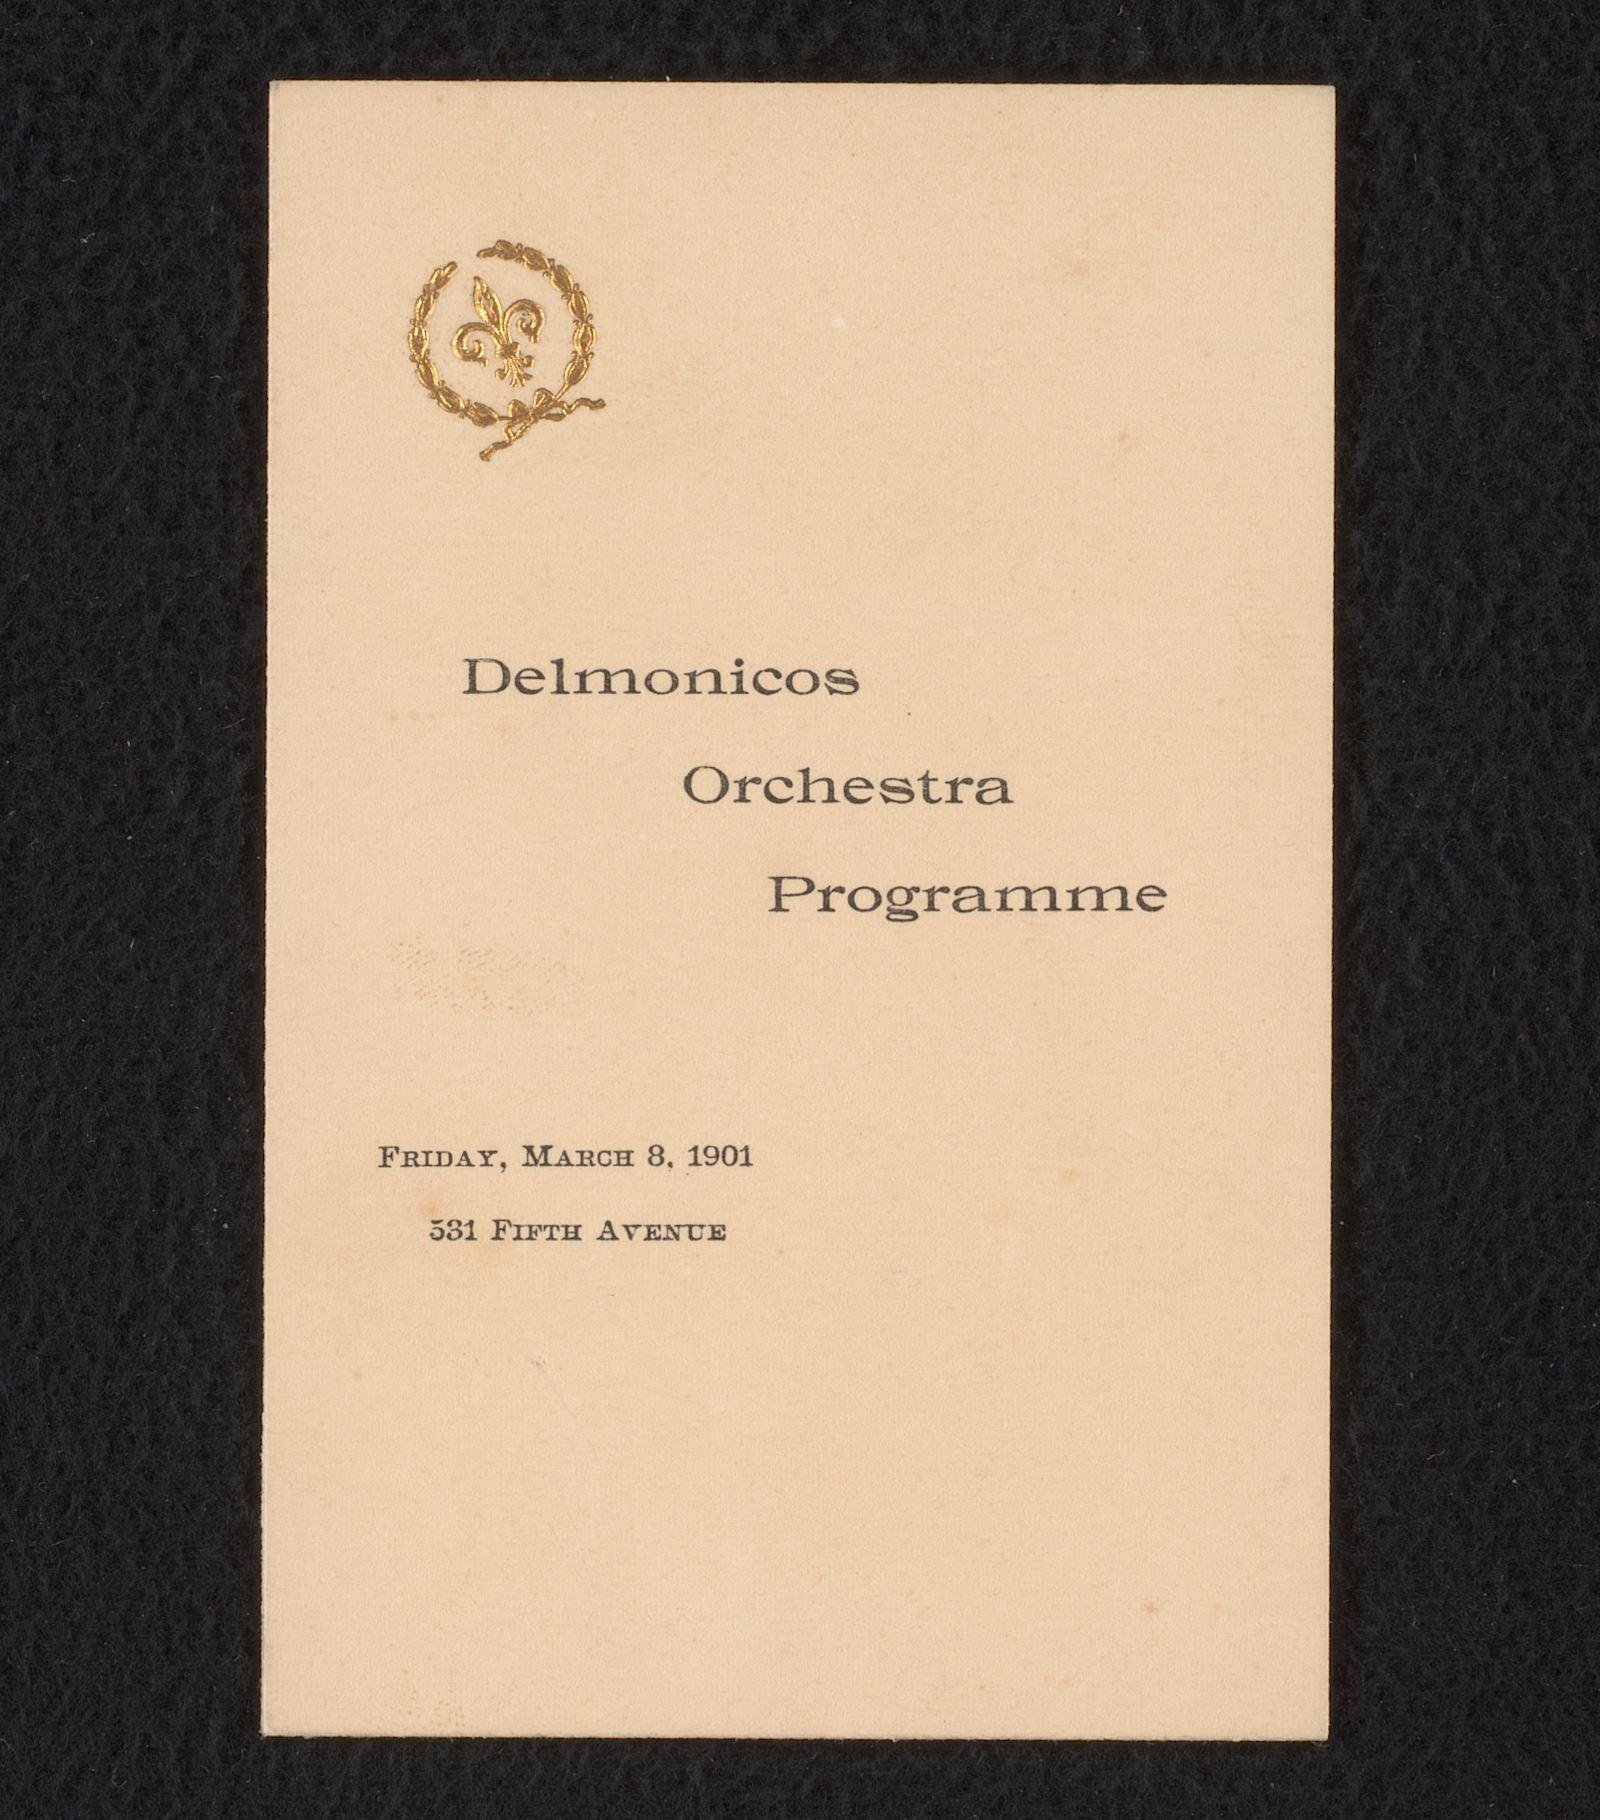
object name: text sheet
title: Programma van het concert van het Delmonicos Orchestra op 8 maart 1901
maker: Anonymous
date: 1901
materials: paper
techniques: printing, letterpress printing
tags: fleur-de-lis ~ ornament, garland, wreath, listening to music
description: Bij gebrek aan gegevens over de vervaardiger is voor de bepaling van de rechten van dit object gebruik gemaakt van de vervaardigingsdatum.